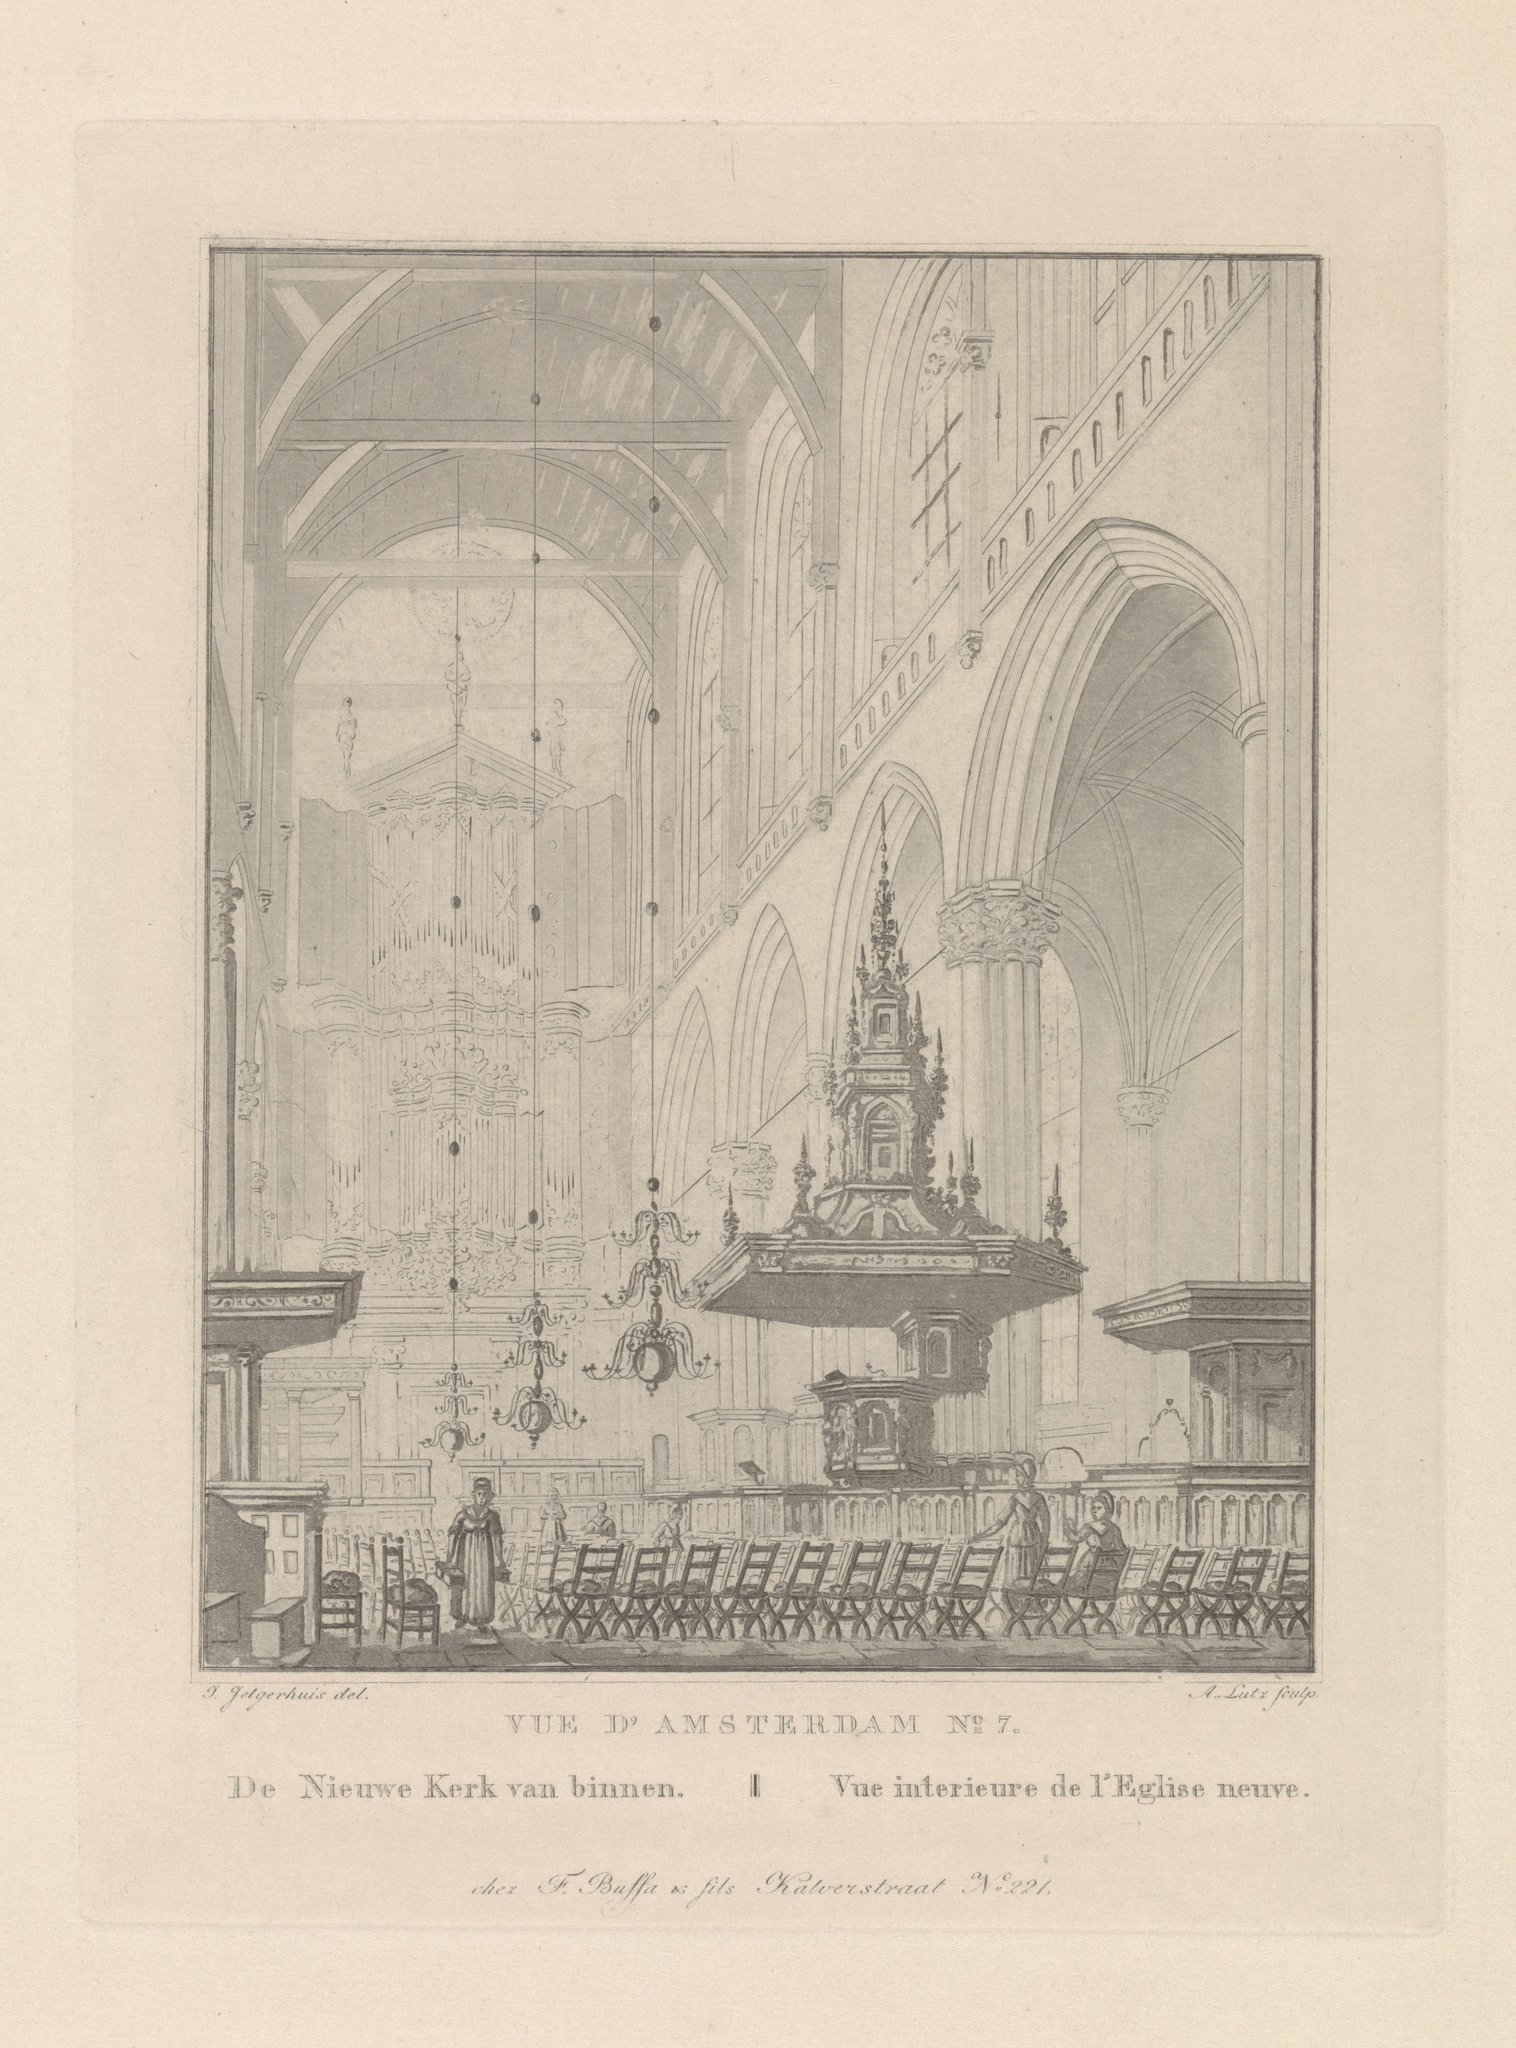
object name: print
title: Gezichten op Amsterdam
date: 1824-1825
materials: paper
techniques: aquatint, etching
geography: the hague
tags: interior of church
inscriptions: collector's mark: Lugt 2233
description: Interieur van het schip van de Nieuwe Kerk te Amsterdam, gezien naar het orgel. Rechts de preekstoel.